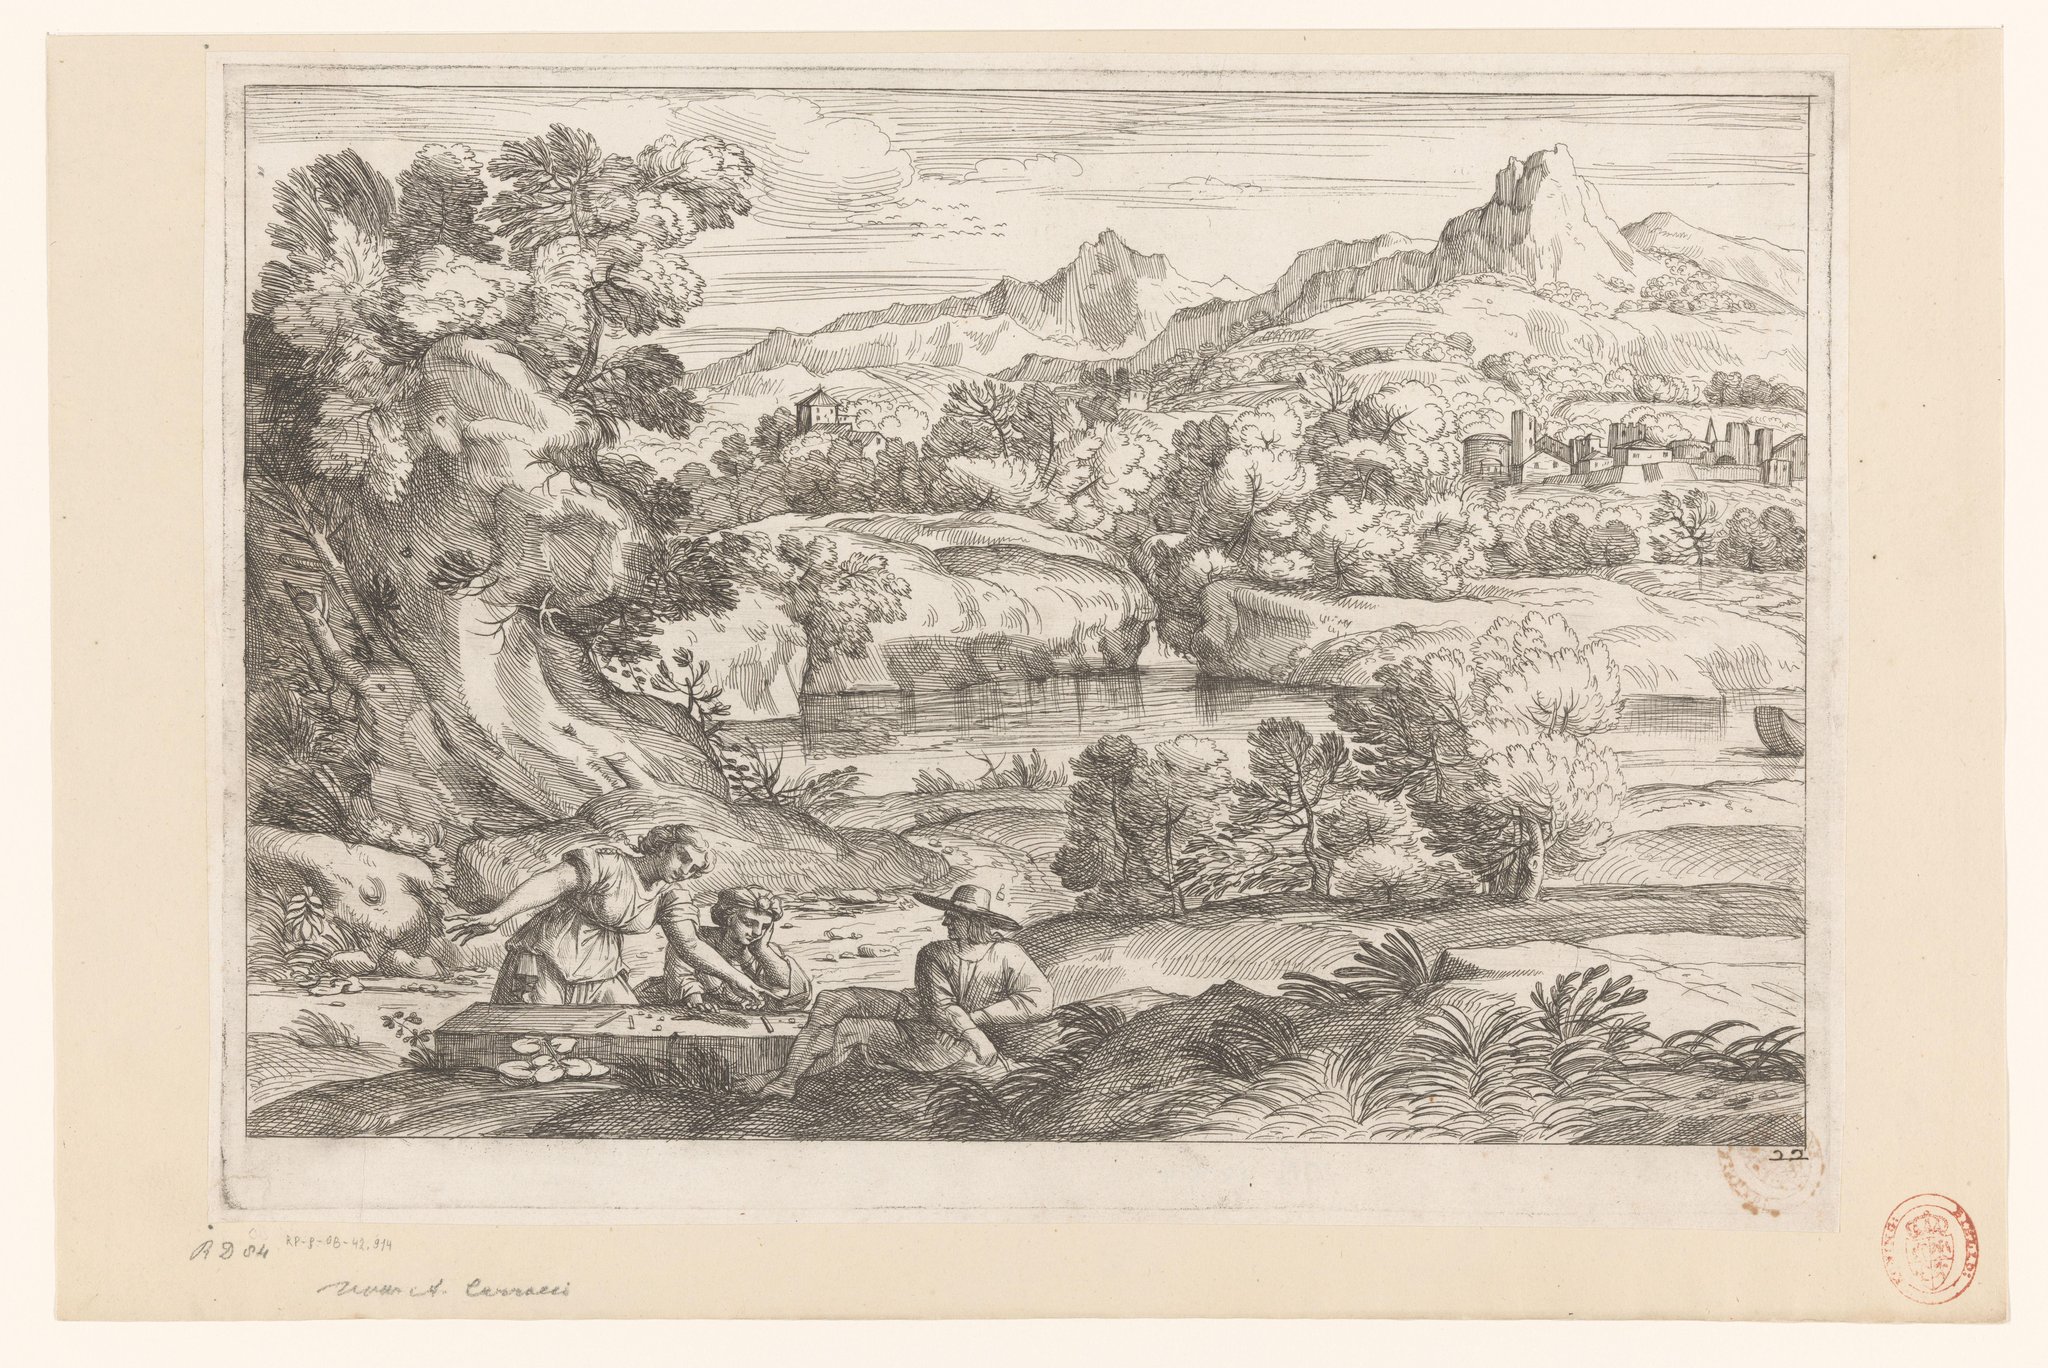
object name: print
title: Rivierlandschap met spelende figuren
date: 1659-1695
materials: paper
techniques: engraving, etching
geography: france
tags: landscapes, board-games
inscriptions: collector's mark: Lugt 240